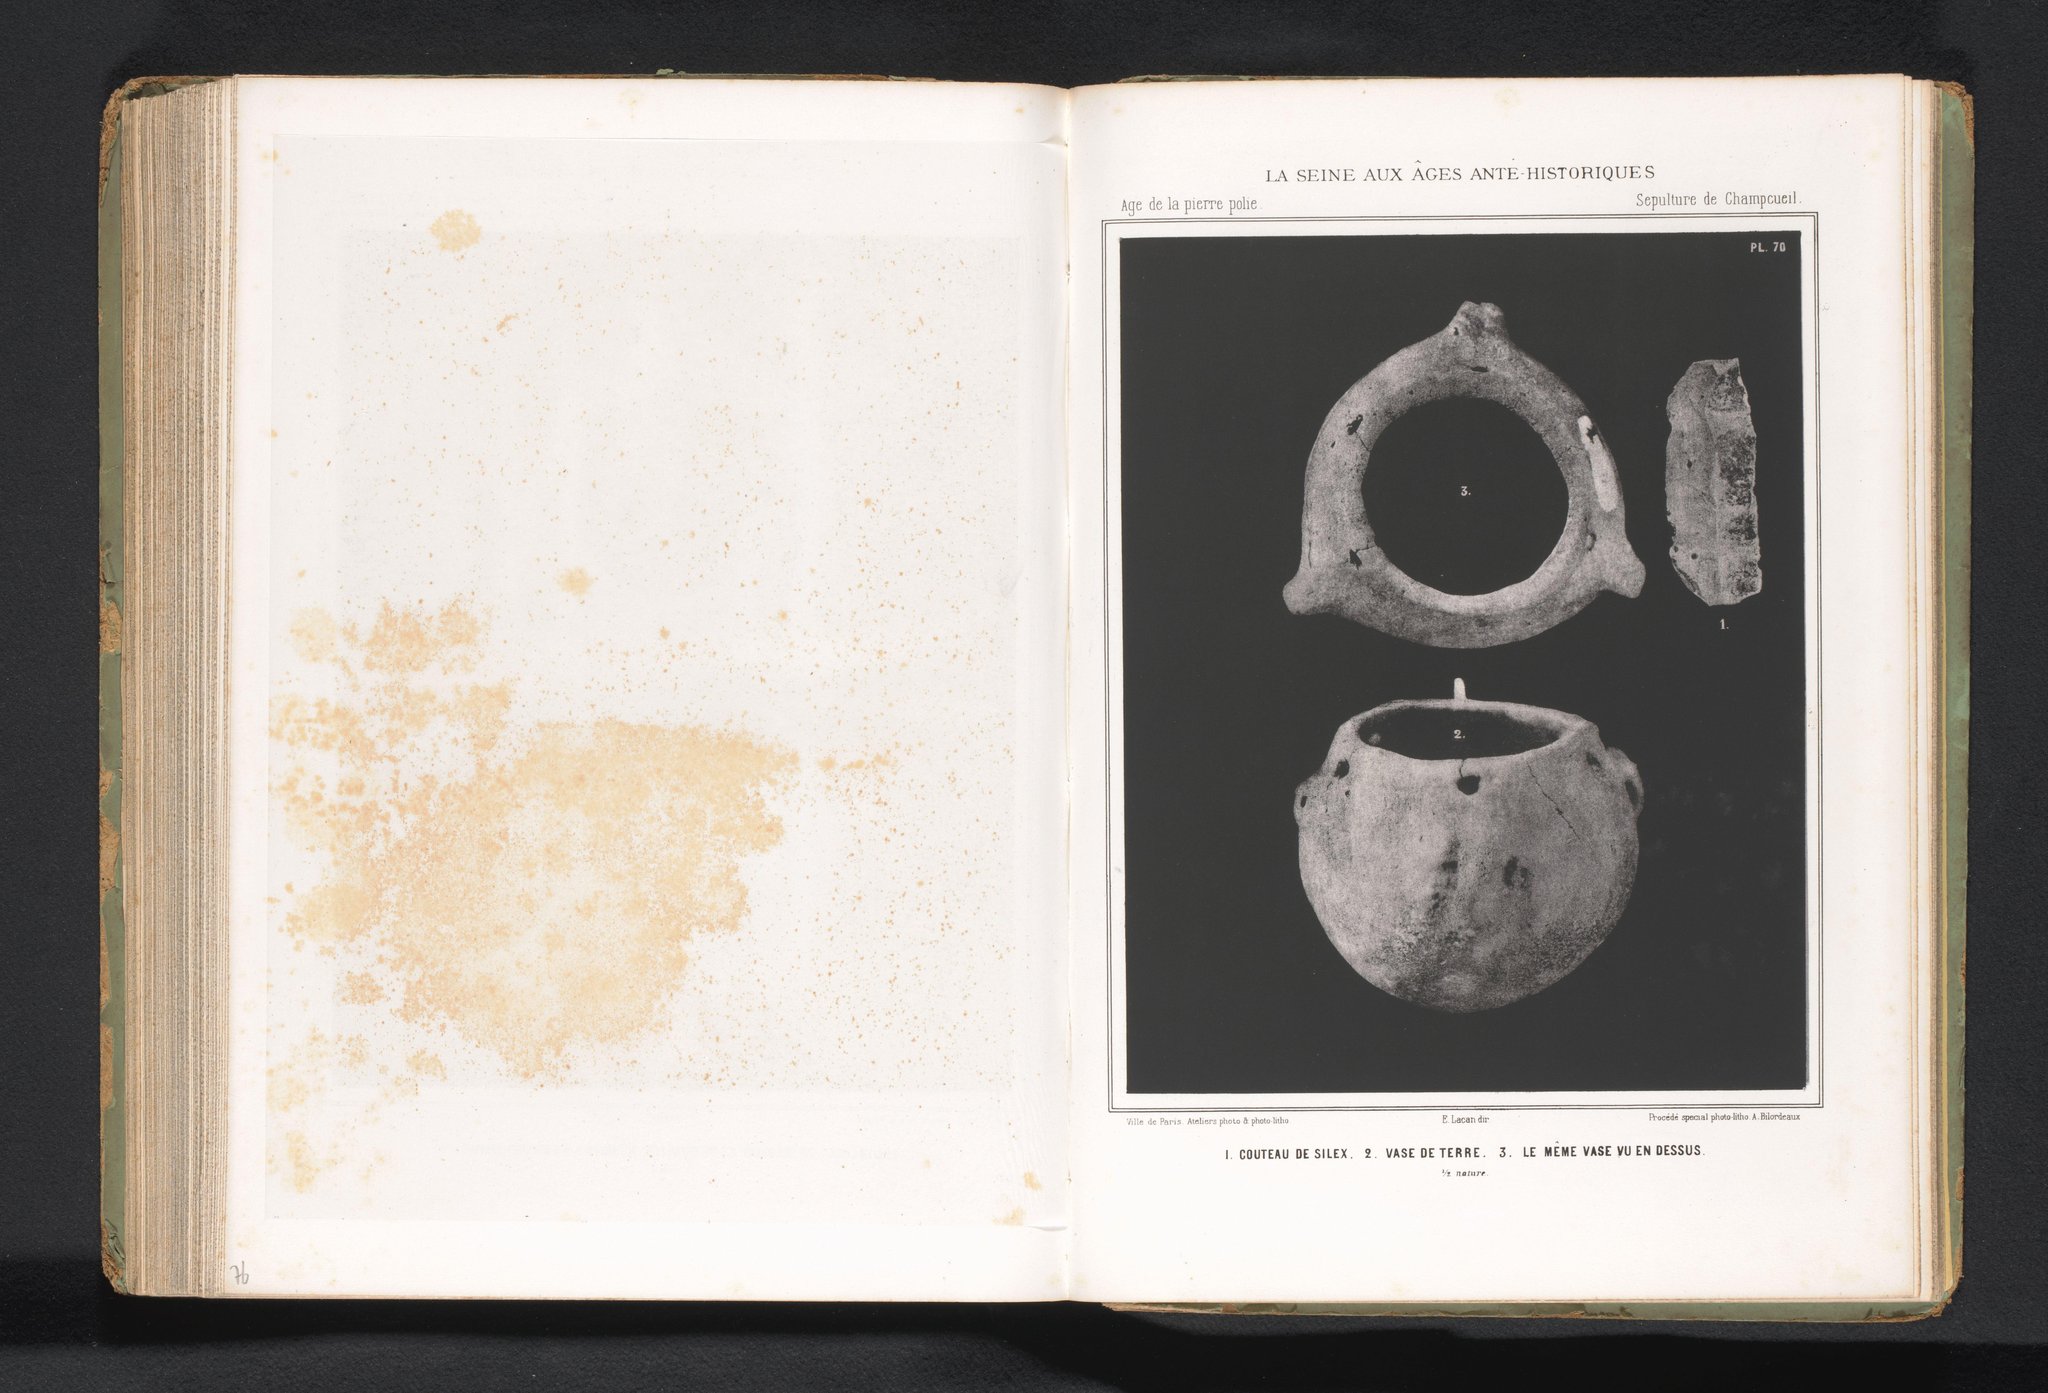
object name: page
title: Vuurstenen mes en twee aanzichten van een aardewerk vaas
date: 1864-1869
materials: paper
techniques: photolithography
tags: container of stone: stone vase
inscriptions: inscription: ‘1. COUTEAU SILEX. 2. VASE DE TERRE. 3. LE MÊME VASE VU EN DESSUS.’, inscription: ‘1/2 nature’, inscription: ‘Procédé spécial photo-litho. A. Bilordeaux’, inscription: ‘PL.70’